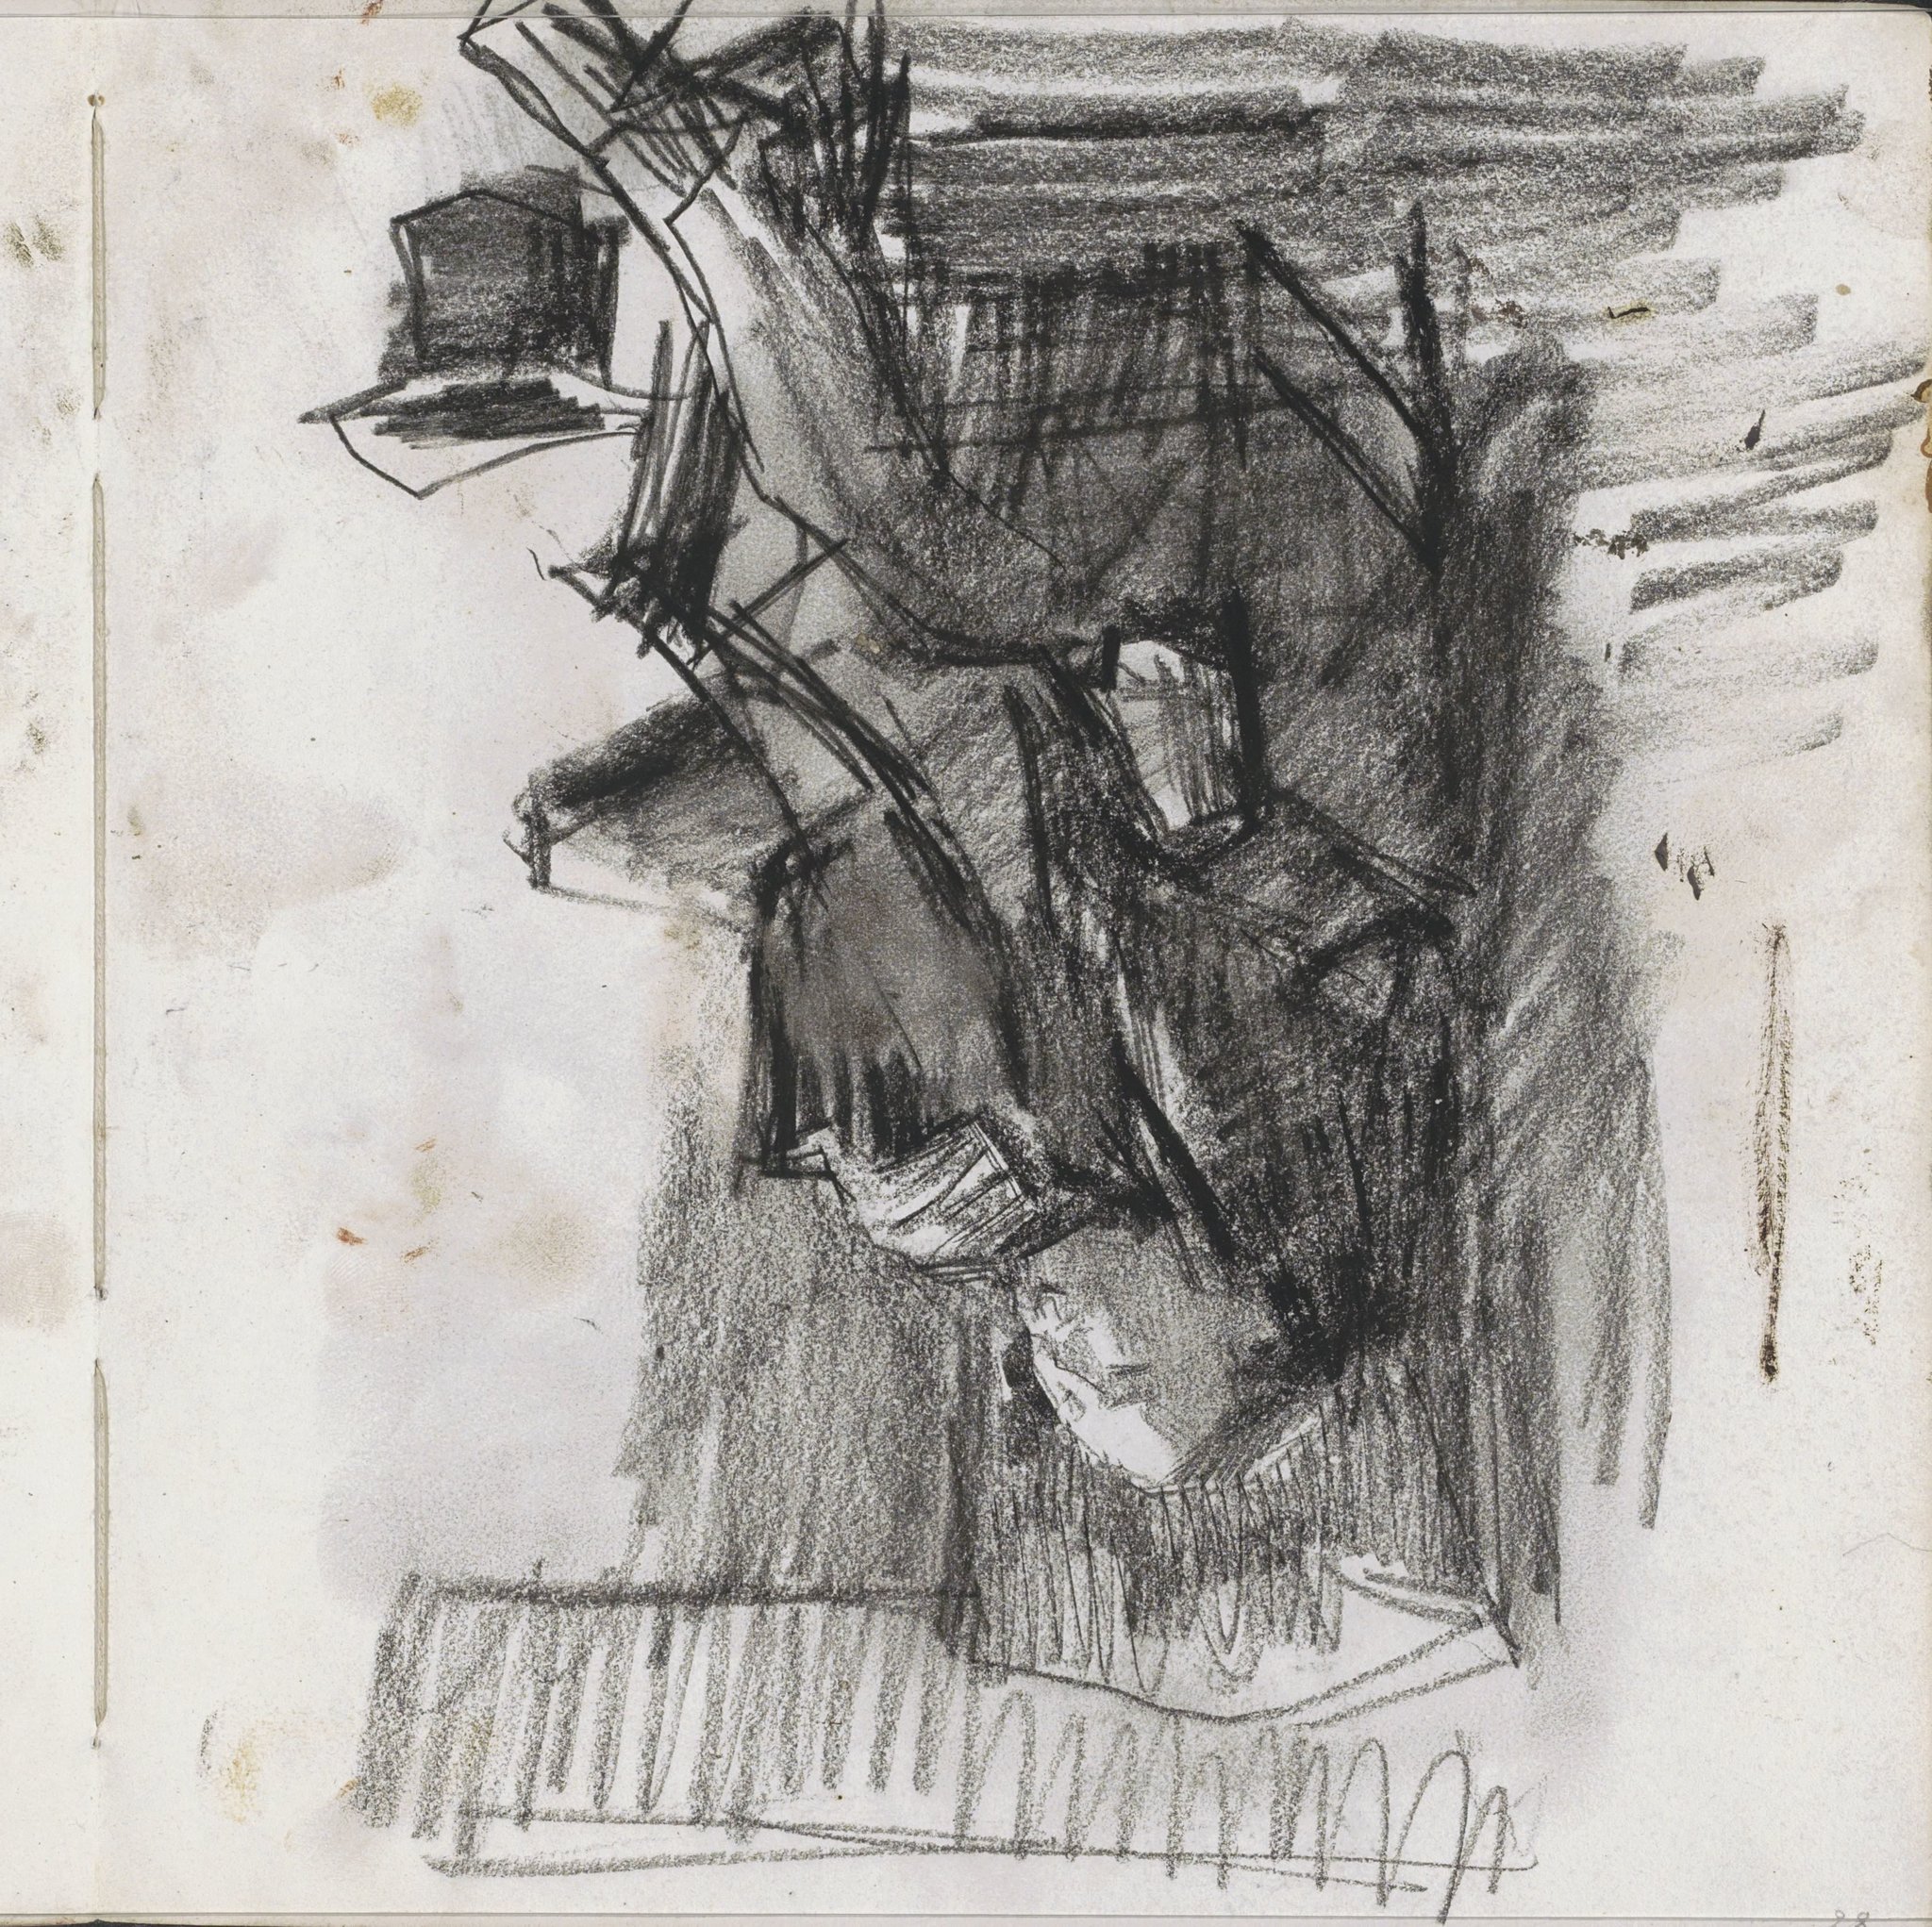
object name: sketchbook leaf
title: Man in een fauteuil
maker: isaac israels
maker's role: draughtsman, painter, print maker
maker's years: 1865-1934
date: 1875-1934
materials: chalk, paper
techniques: stumping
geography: the hague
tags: adult man (+ sitting), armchair, seat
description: Blad 28 recto uit schetsboek IX met 28 bladen.